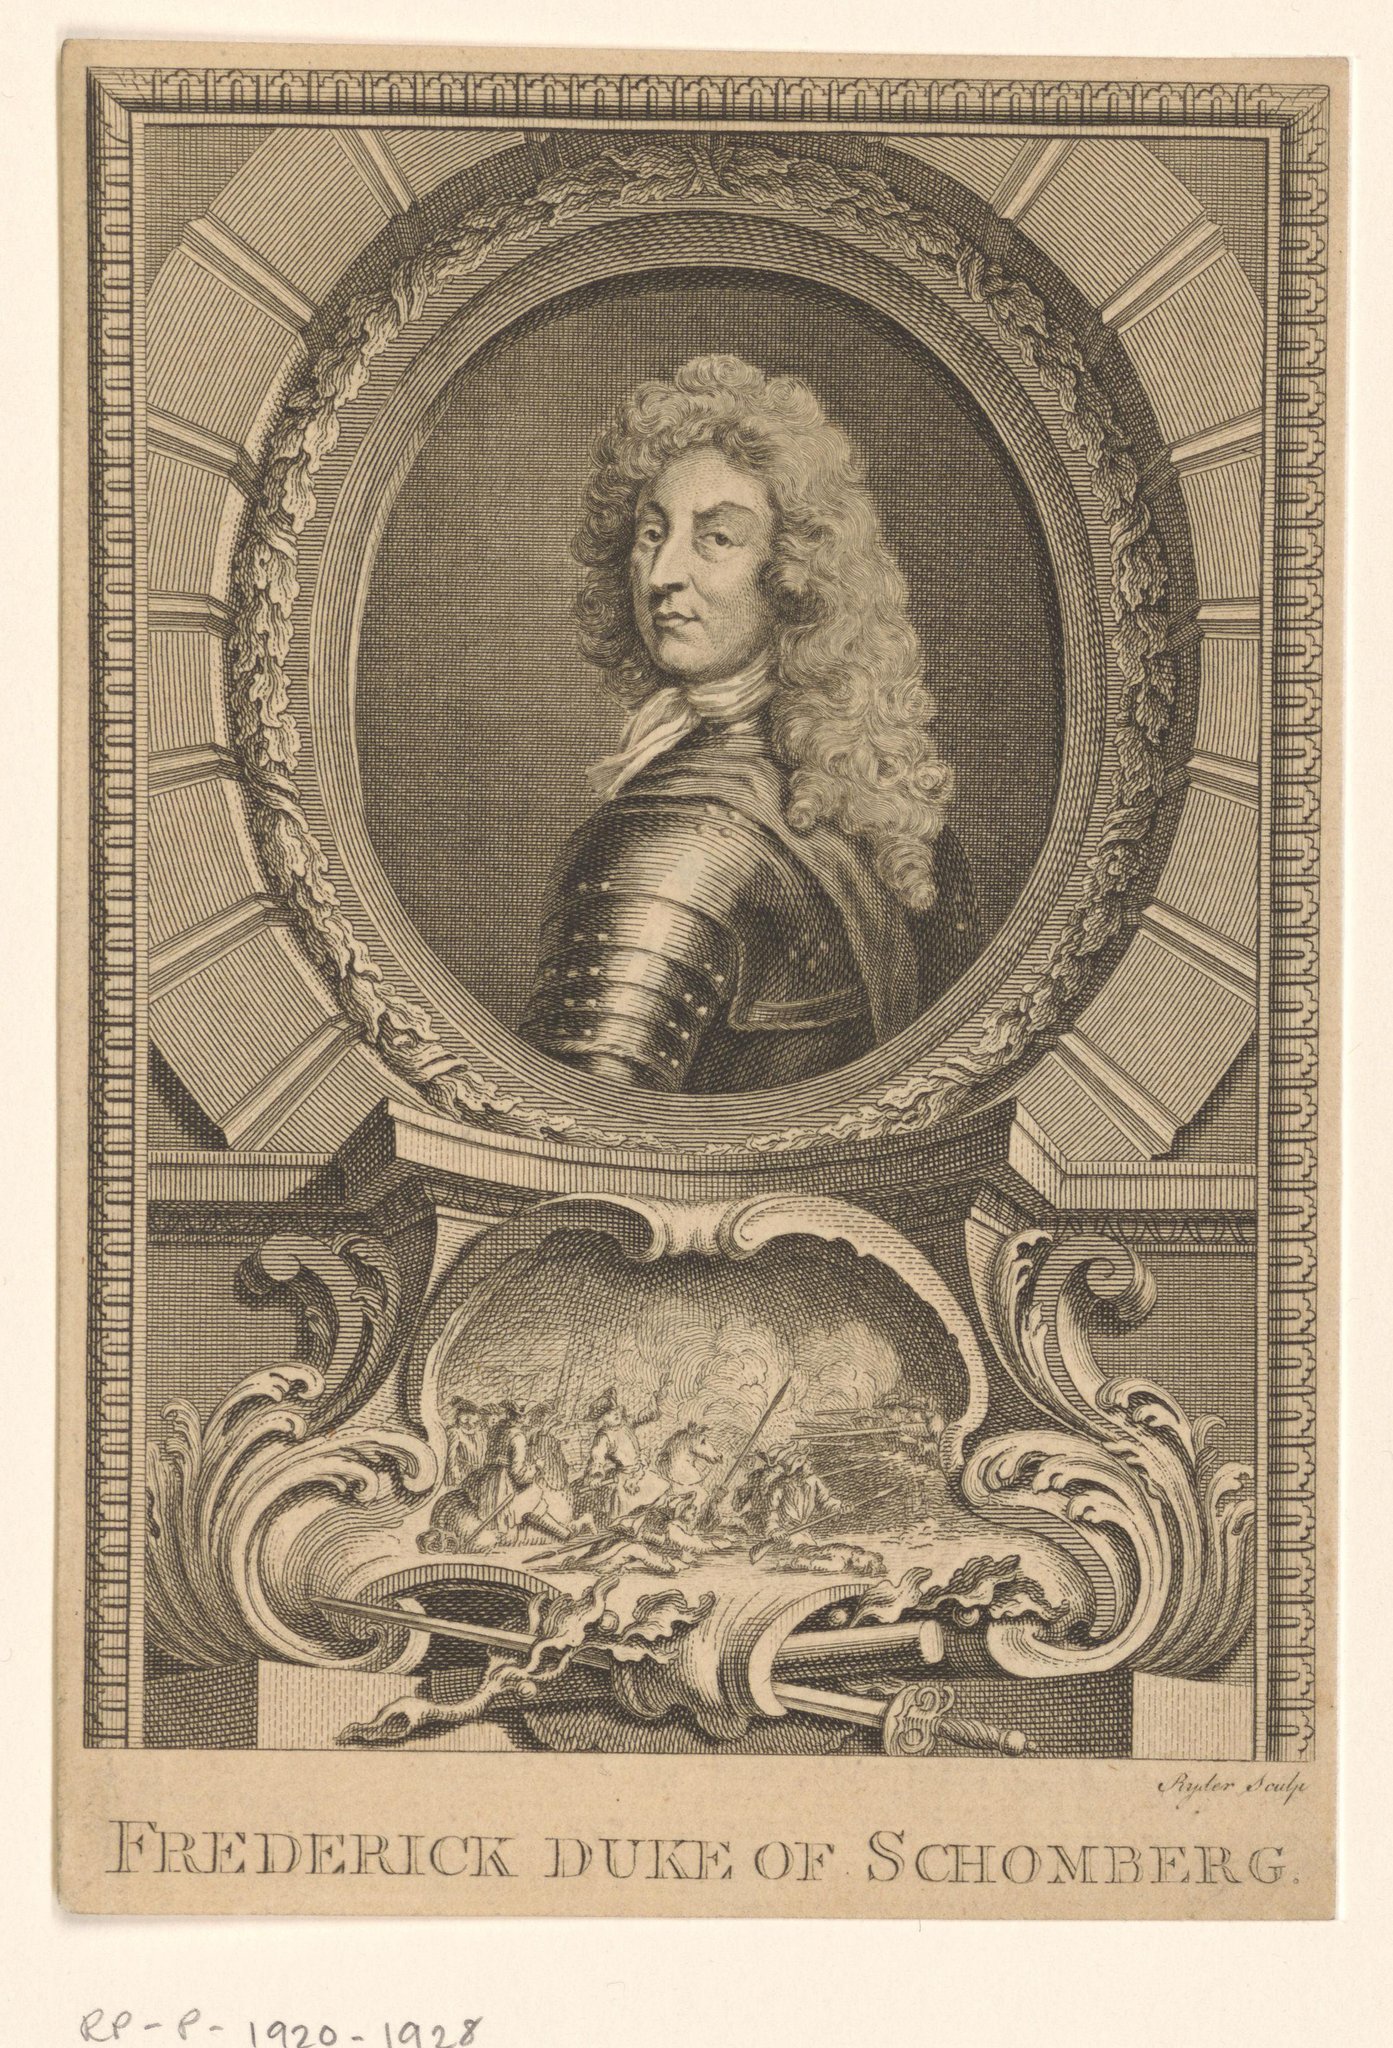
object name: print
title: Portret van hertog Frederik van Schomberg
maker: thomas ryder (i)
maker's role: print maker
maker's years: 1746-1810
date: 1756-1810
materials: paper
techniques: engraving, etching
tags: commander-in-chief, general, marshal, historical persons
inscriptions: collector's mark: Lugt 2228